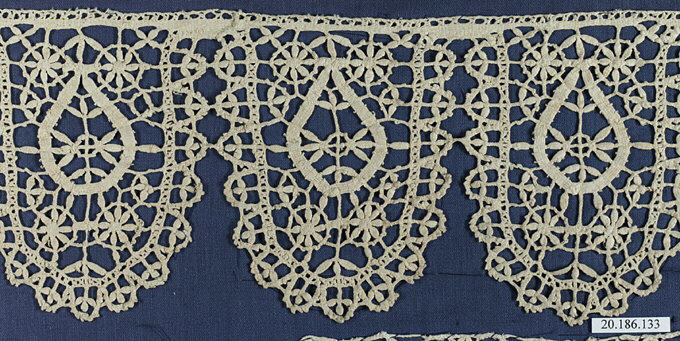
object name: edging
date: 1601-1700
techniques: lace